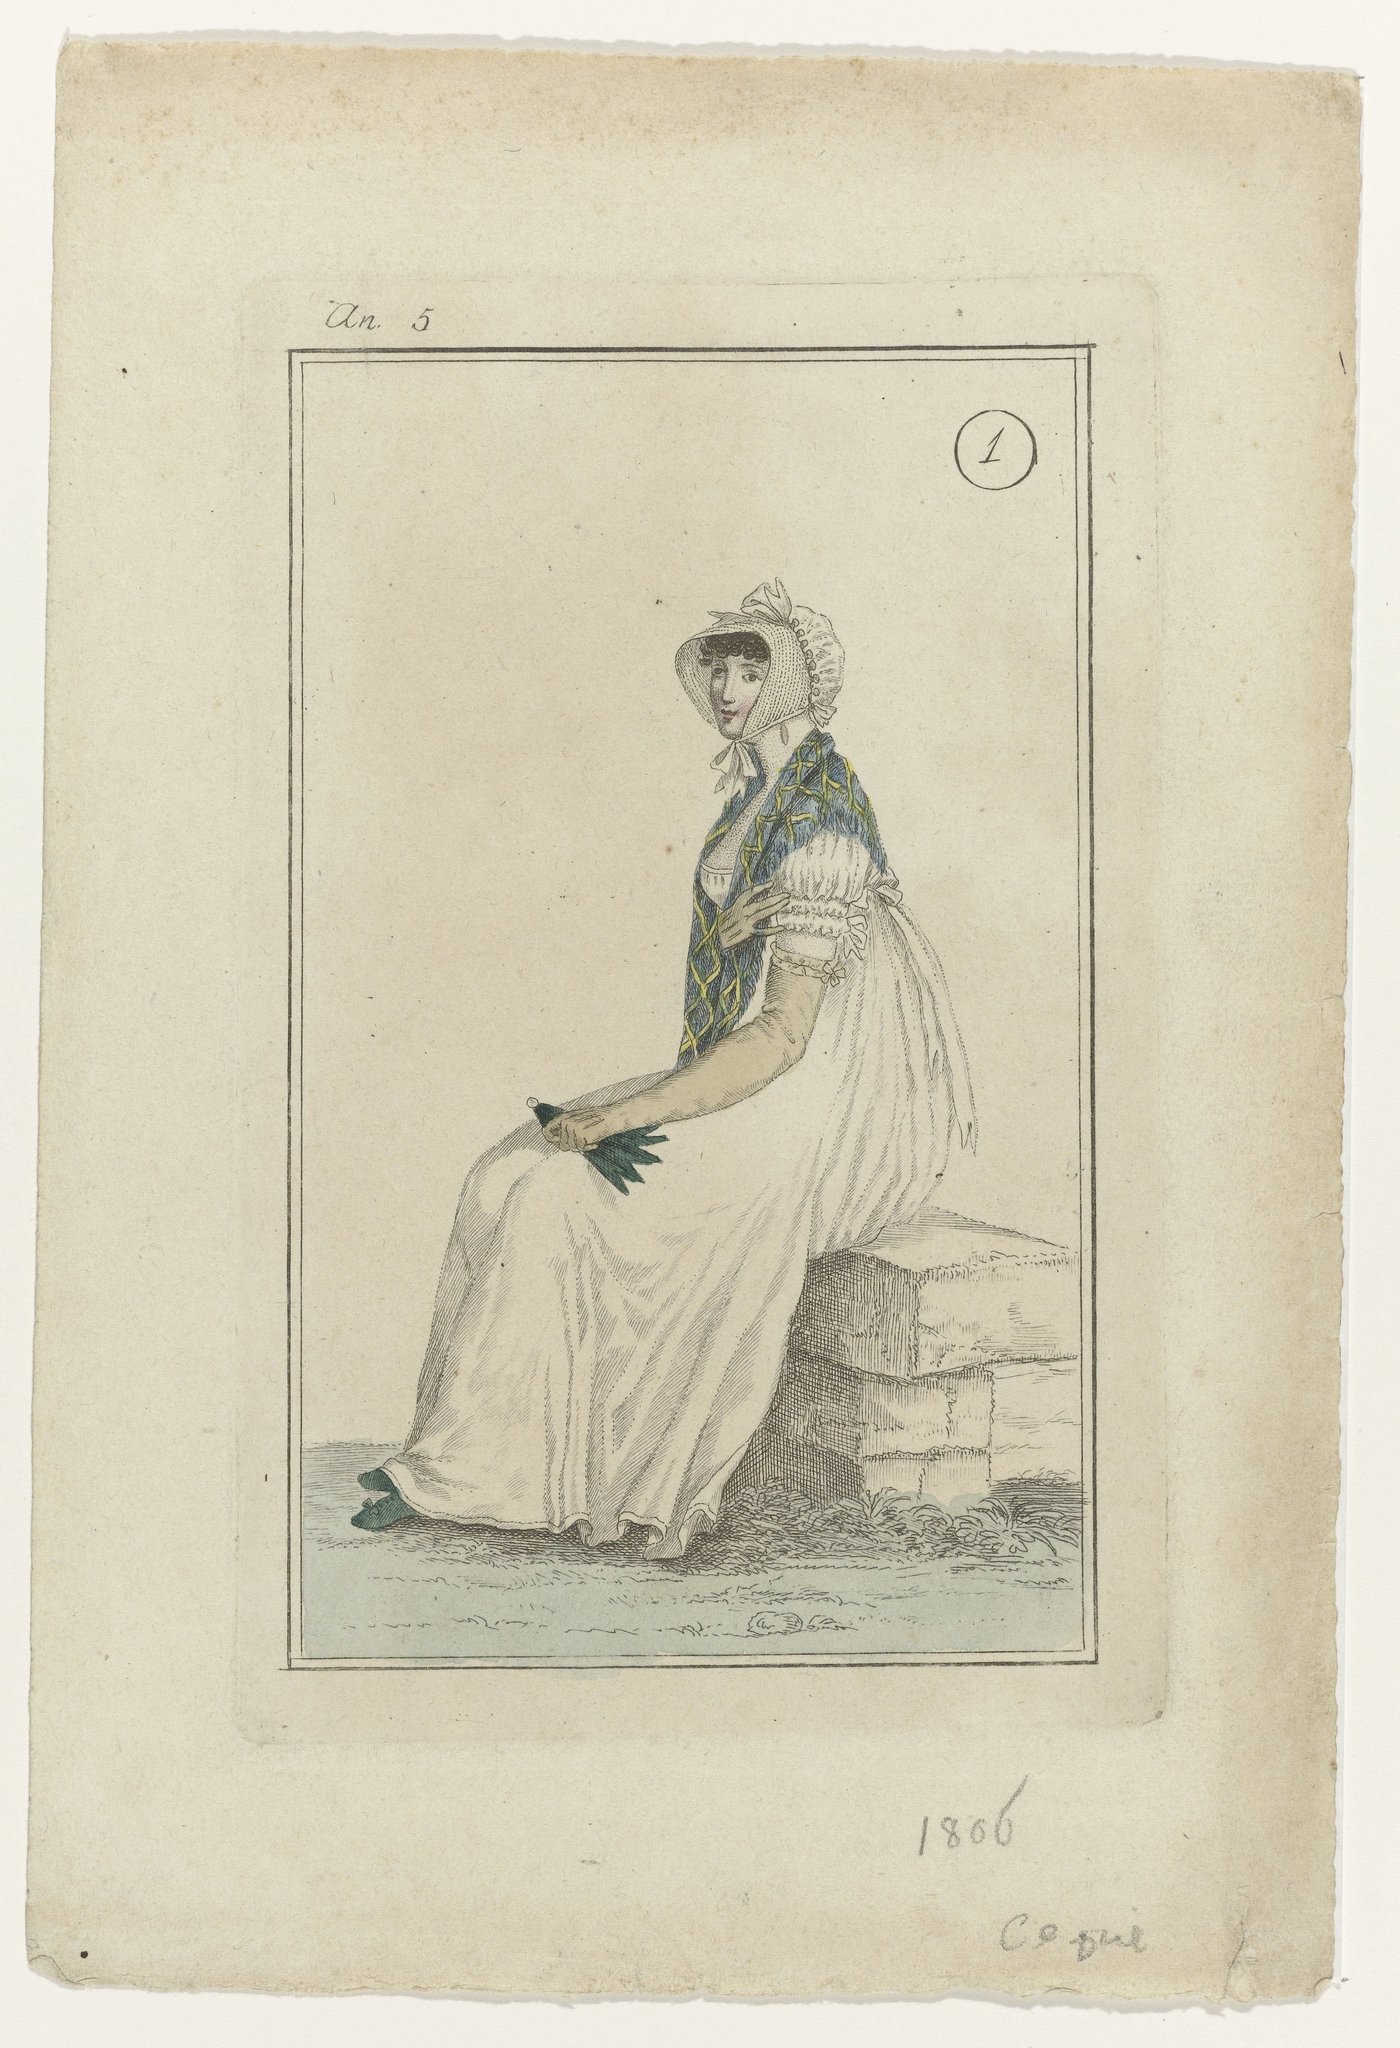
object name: fashion print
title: Journal des Dames et des Modes, kopie, An 5, No. 1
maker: Anonymous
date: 1806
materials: paper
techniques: etching, hand coloring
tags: head-gear (+ women's clothes), fashion plates, gloves, mittens, etc. (+ women's clothes), dress, gown (+ women's clothes)